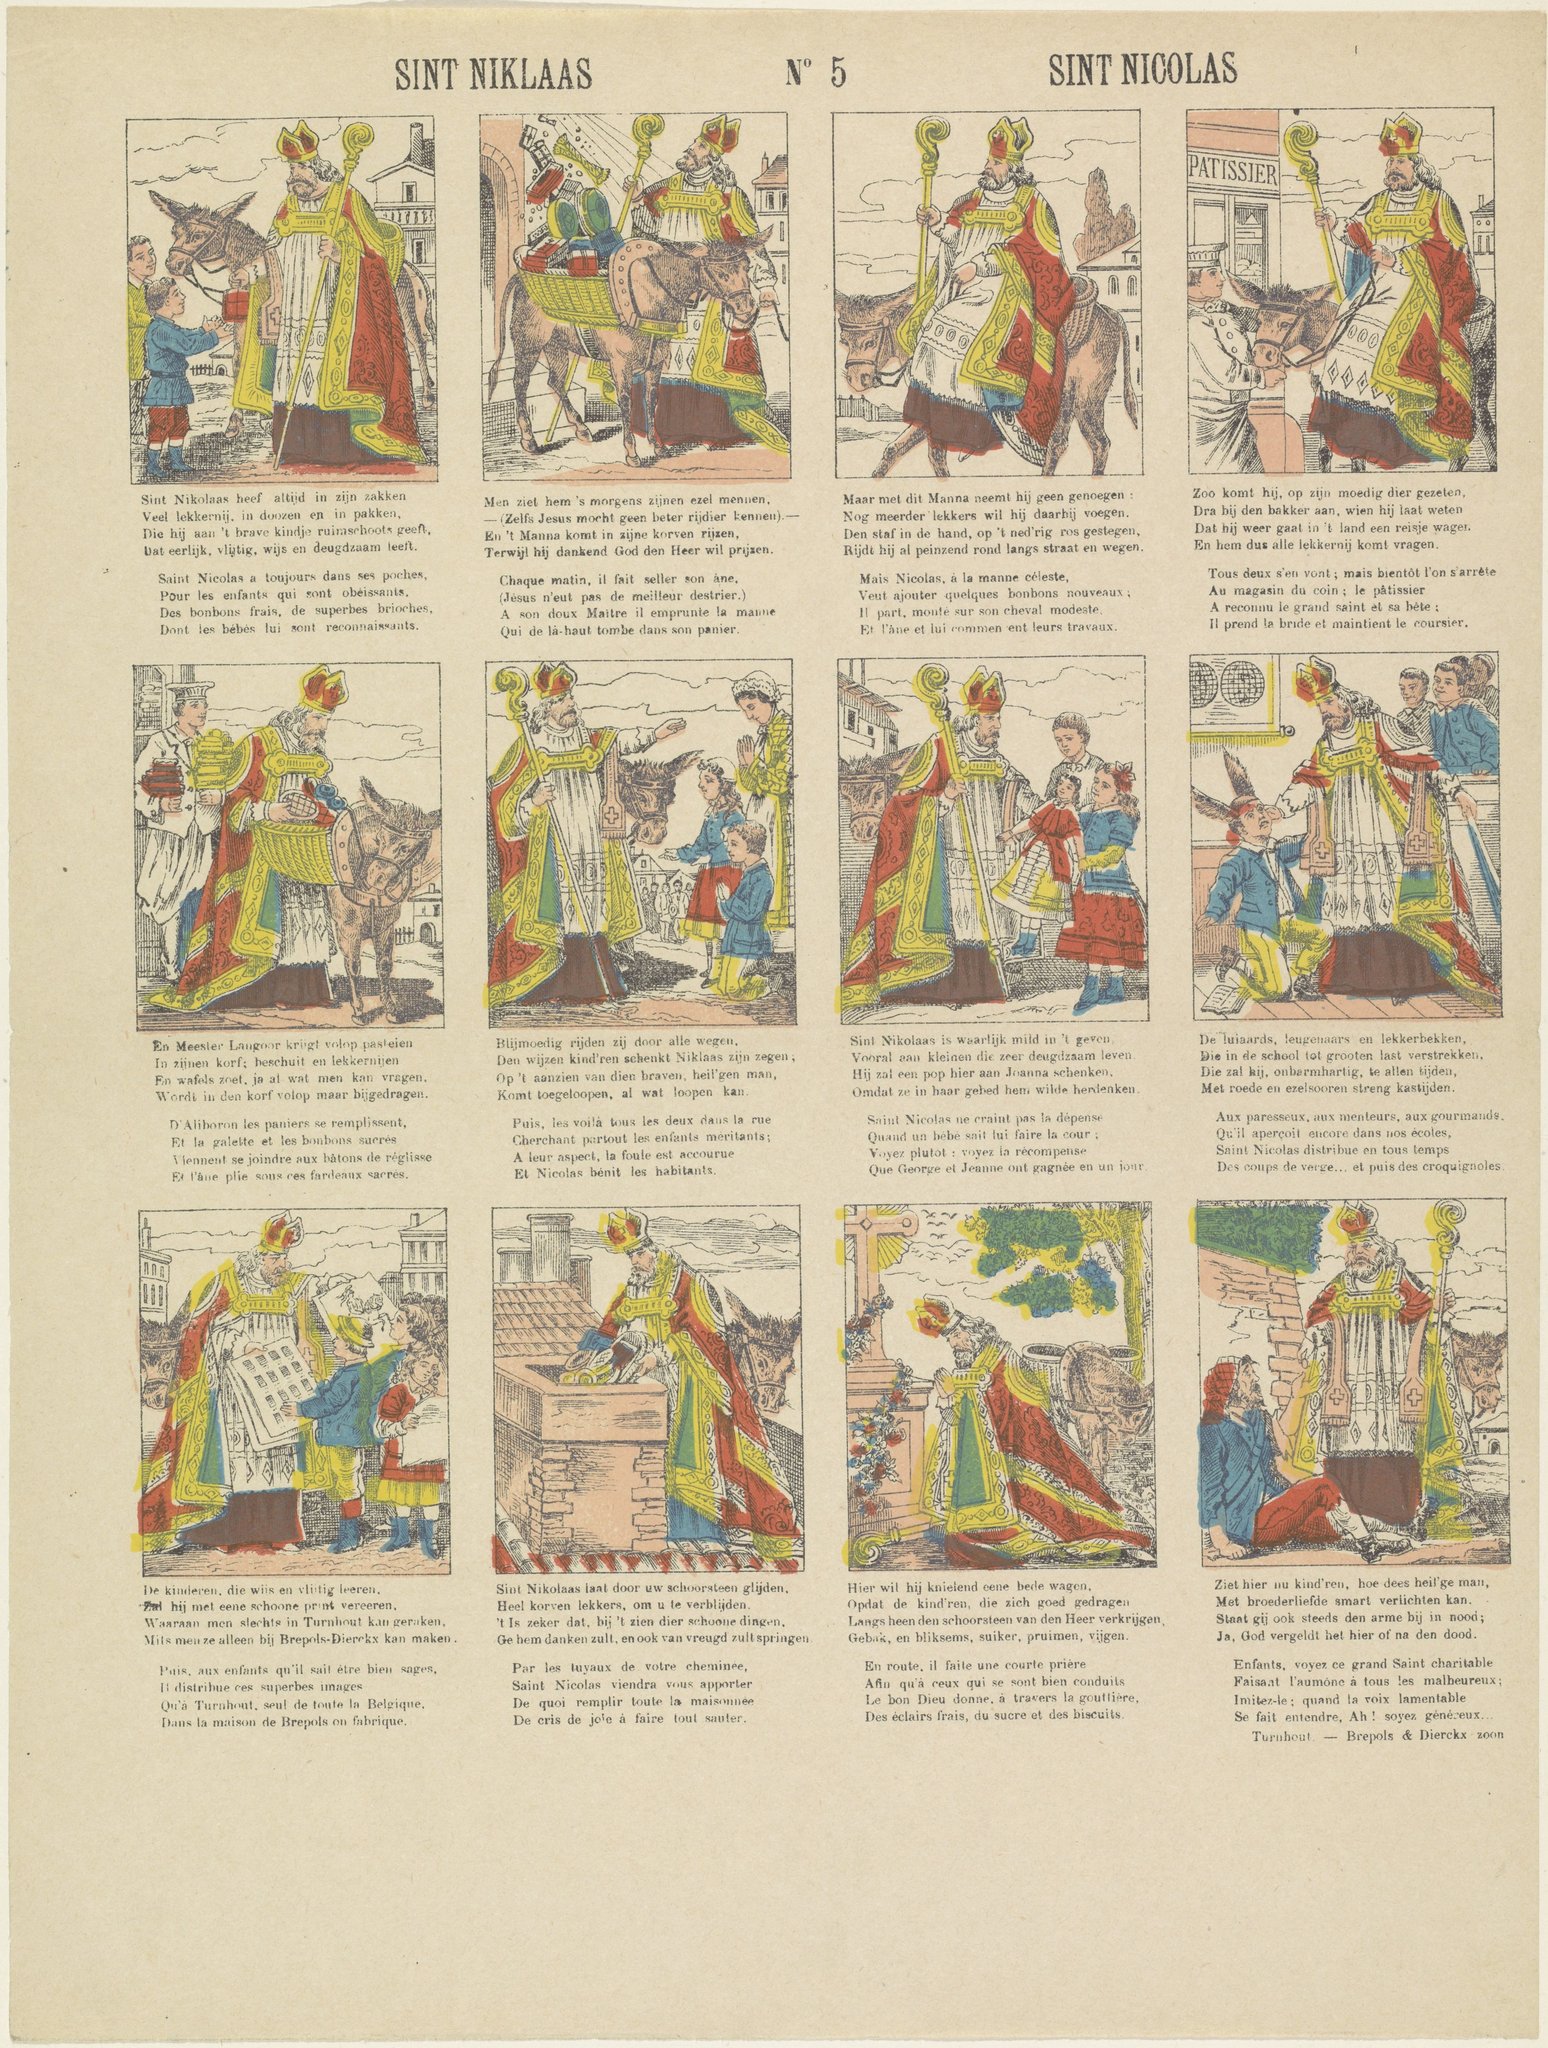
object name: print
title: Sint Niklaas / Sint Nicolas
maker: Anonymous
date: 1833-1911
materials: paper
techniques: lithograph, letterpress printing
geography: turnhout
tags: the bishop nicholas of myra (or bari); possible attributes: anchor, boat, three golden balls (on a book), three purses, three children in a tub, three maidens, festivities on st. nicholas (eve) (december 5)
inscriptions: collector's mark: Lugt 2760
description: Blad met 12 voorstellingen over de feestdag van Sint Nicolaas. Onder elke afbeelding een vierregelig vers in het Nederlands en in het Frans. Genummerd midden boven: No 5.